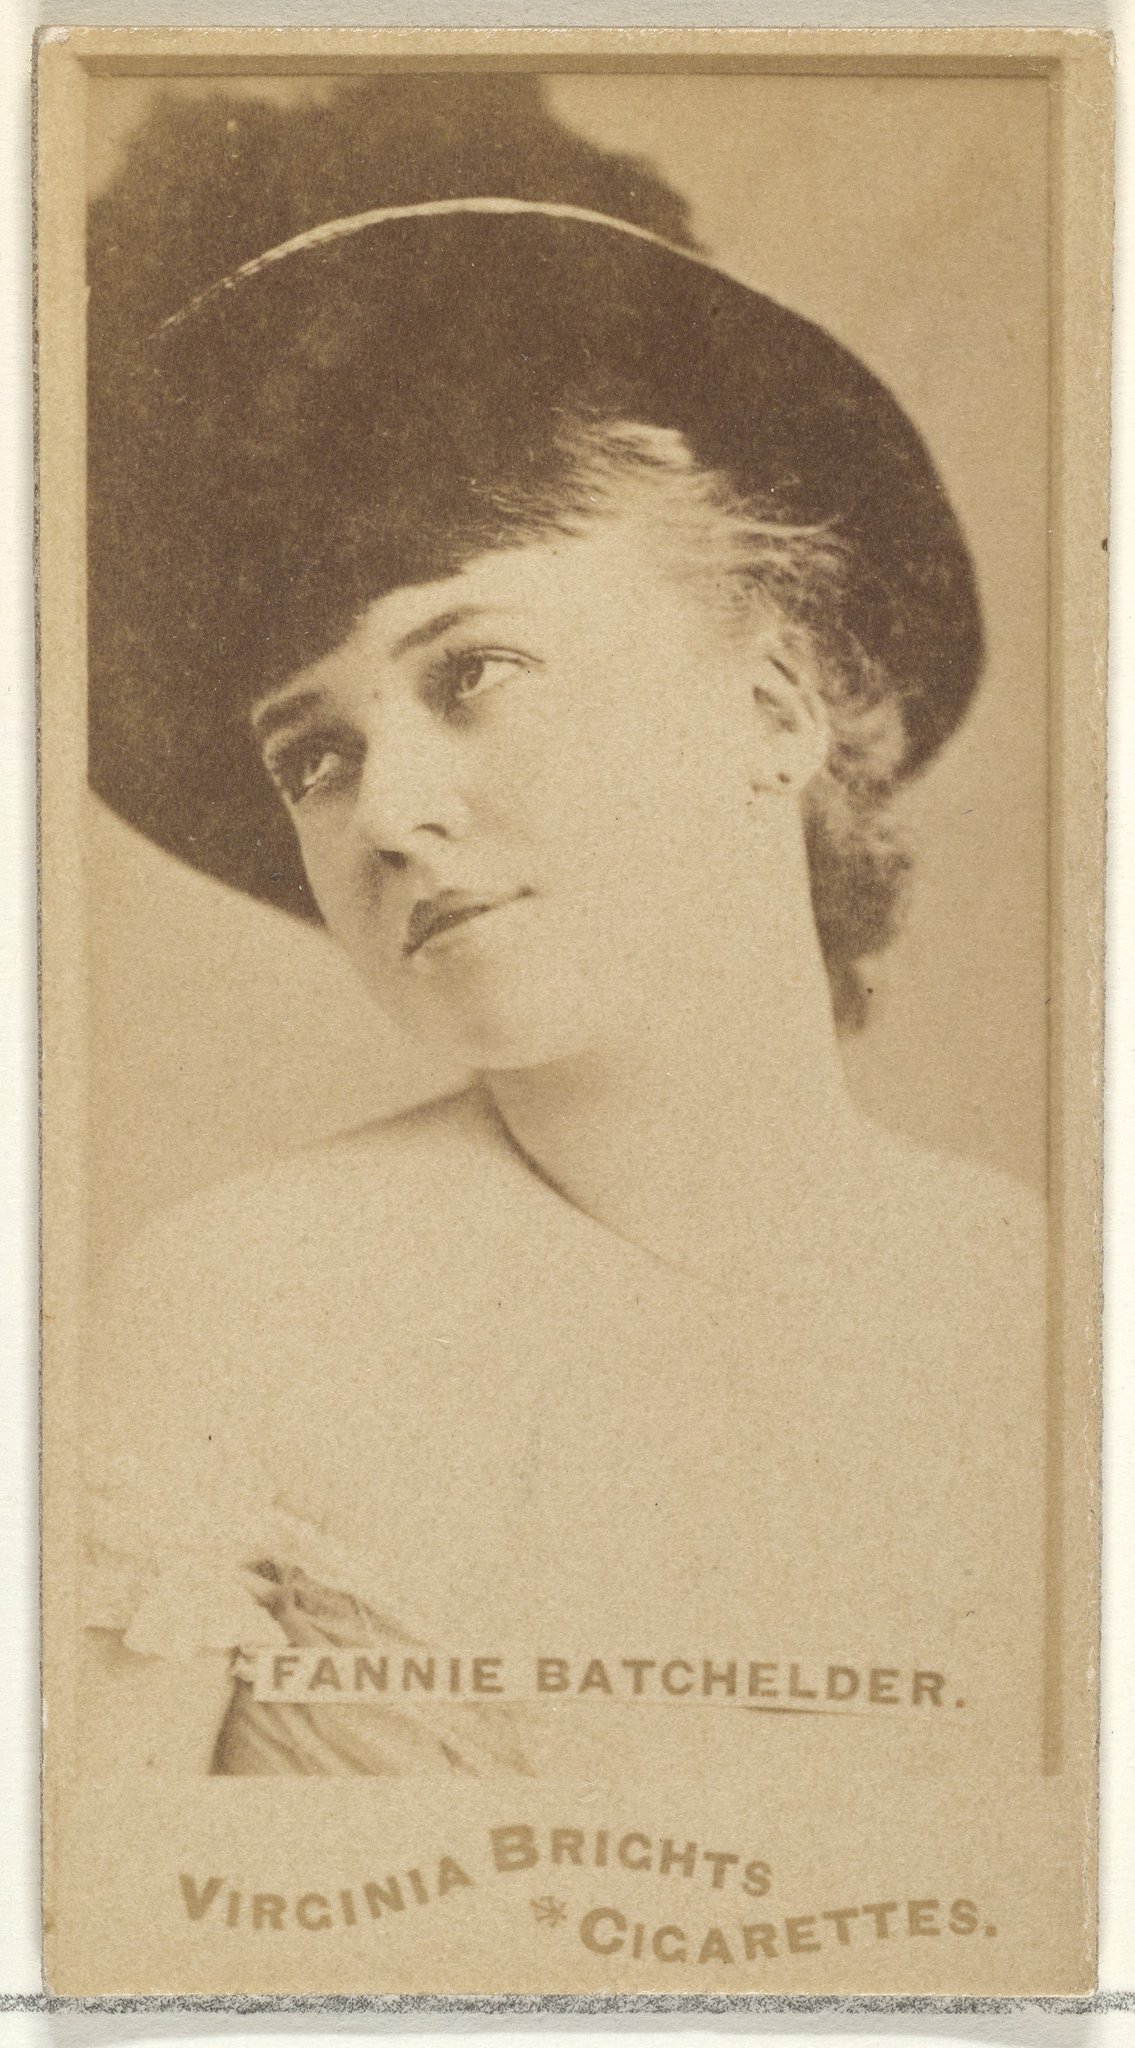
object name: photograph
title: Fannie Batchelder, from the Actors and Actresses series (N45, Type 1) for Virginia Brights Cigarettes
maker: allen & ginter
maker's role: publisher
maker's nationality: american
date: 1888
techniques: albumen silver print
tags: portraits,women,actresses